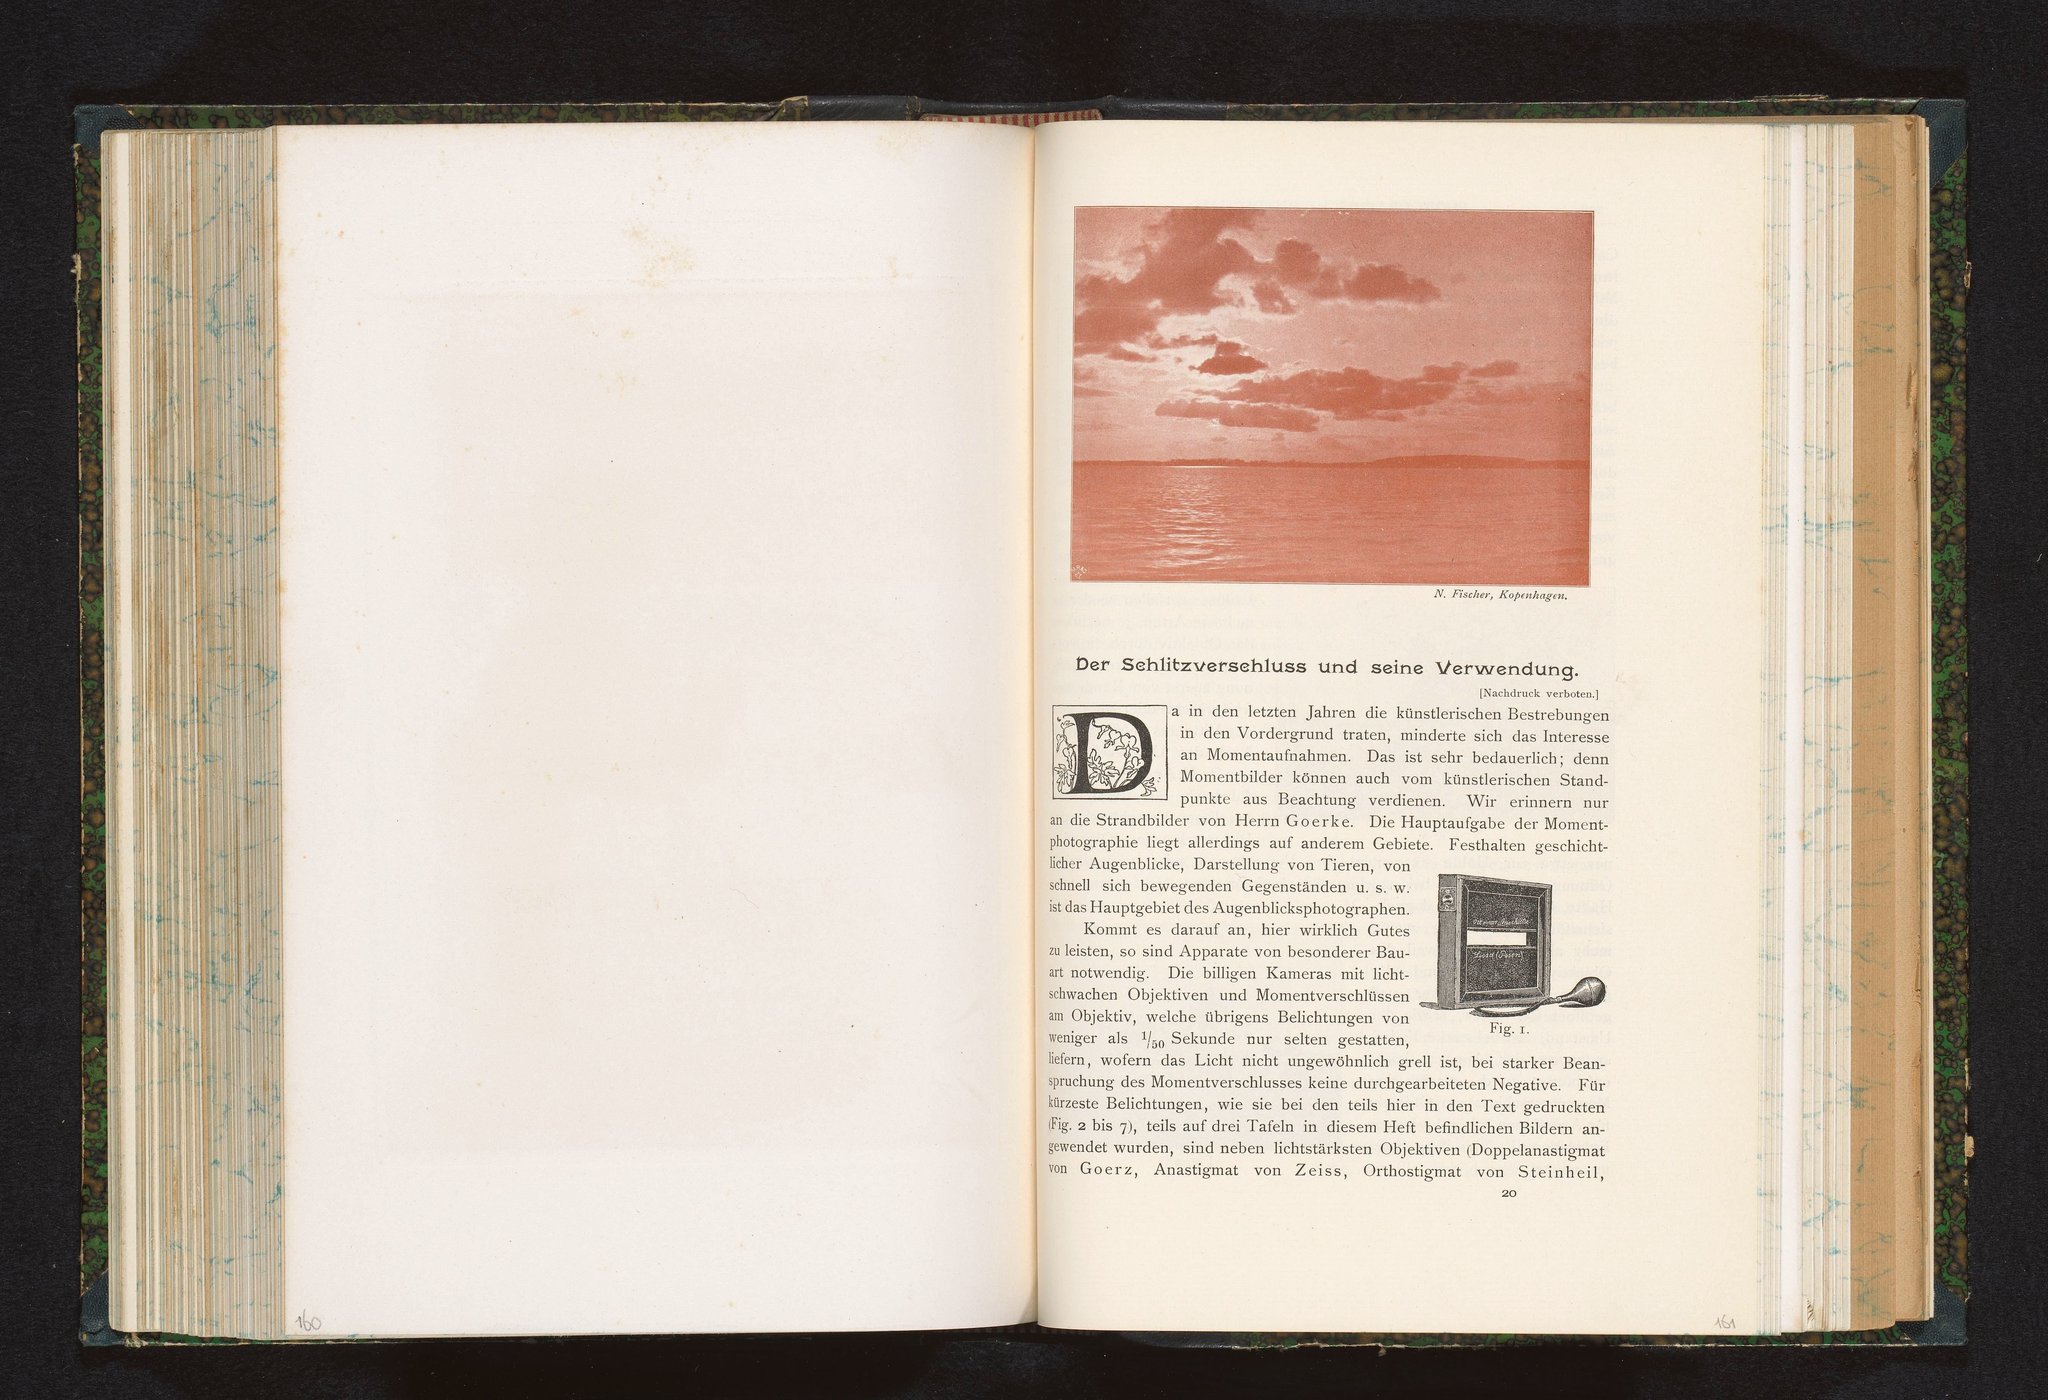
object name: photomechanical print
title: Zeegezicht met land op de achtergrond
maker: niels adam fischer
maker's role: fotograaf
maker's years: 1856-1938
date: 1894-1899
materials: paper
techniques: autotype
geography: berlin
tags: sea (seascape)